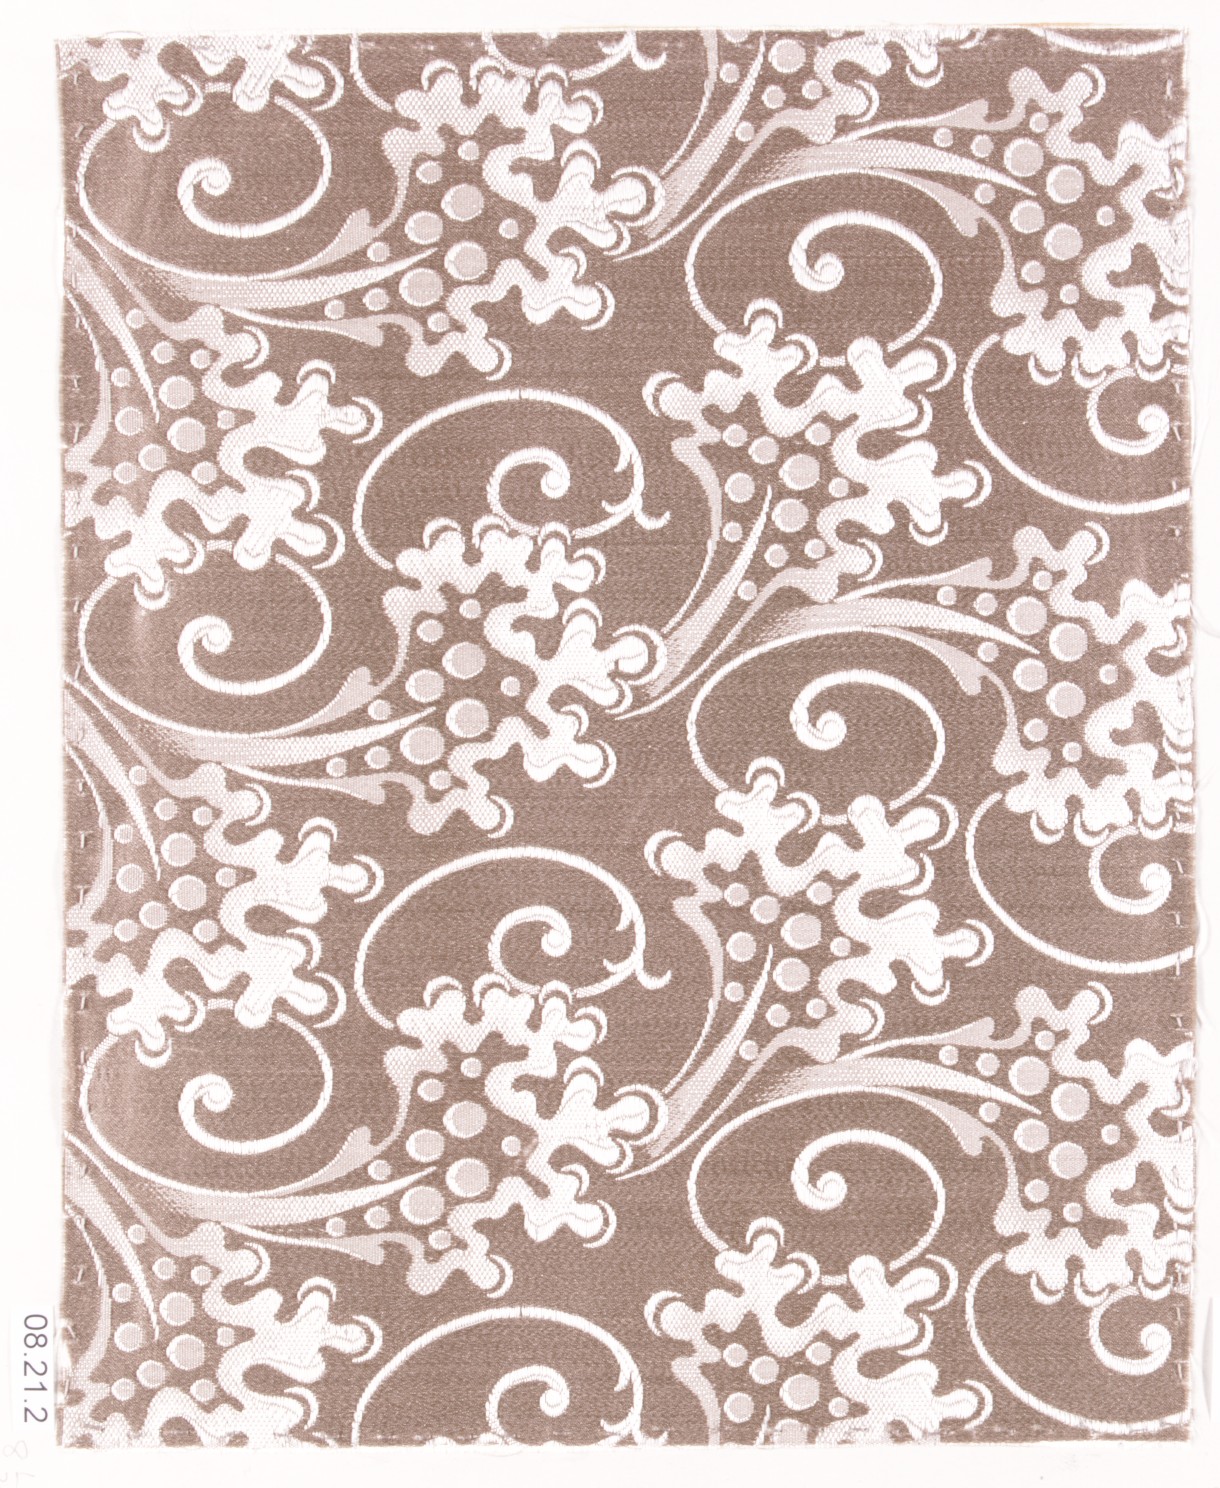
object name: textile sample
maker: Anonymous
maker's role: designer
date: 1900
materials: silk